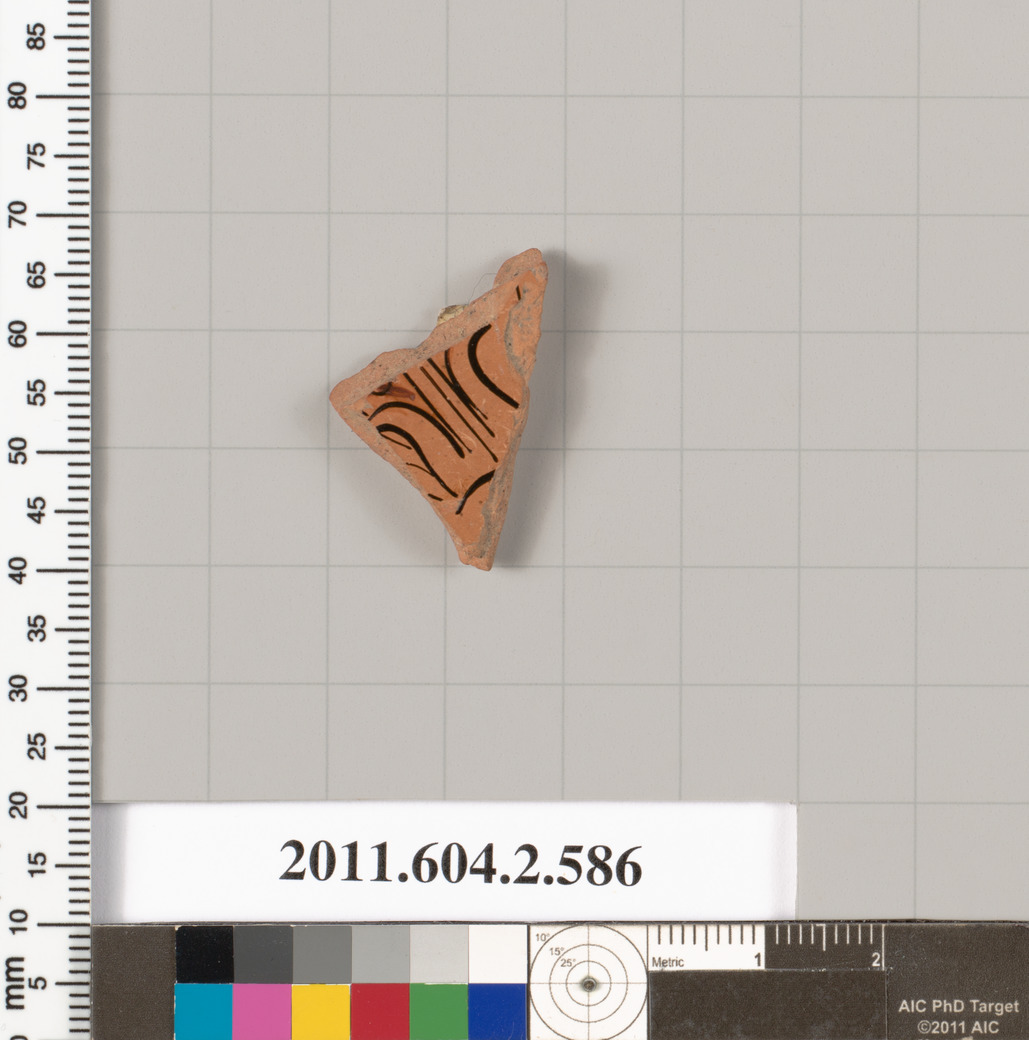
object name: column krater fragment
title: Terracotta fragment of a column-krater (bowl for mixing wine and water)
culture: greek, attic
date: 470-450 BCE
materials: terracotta